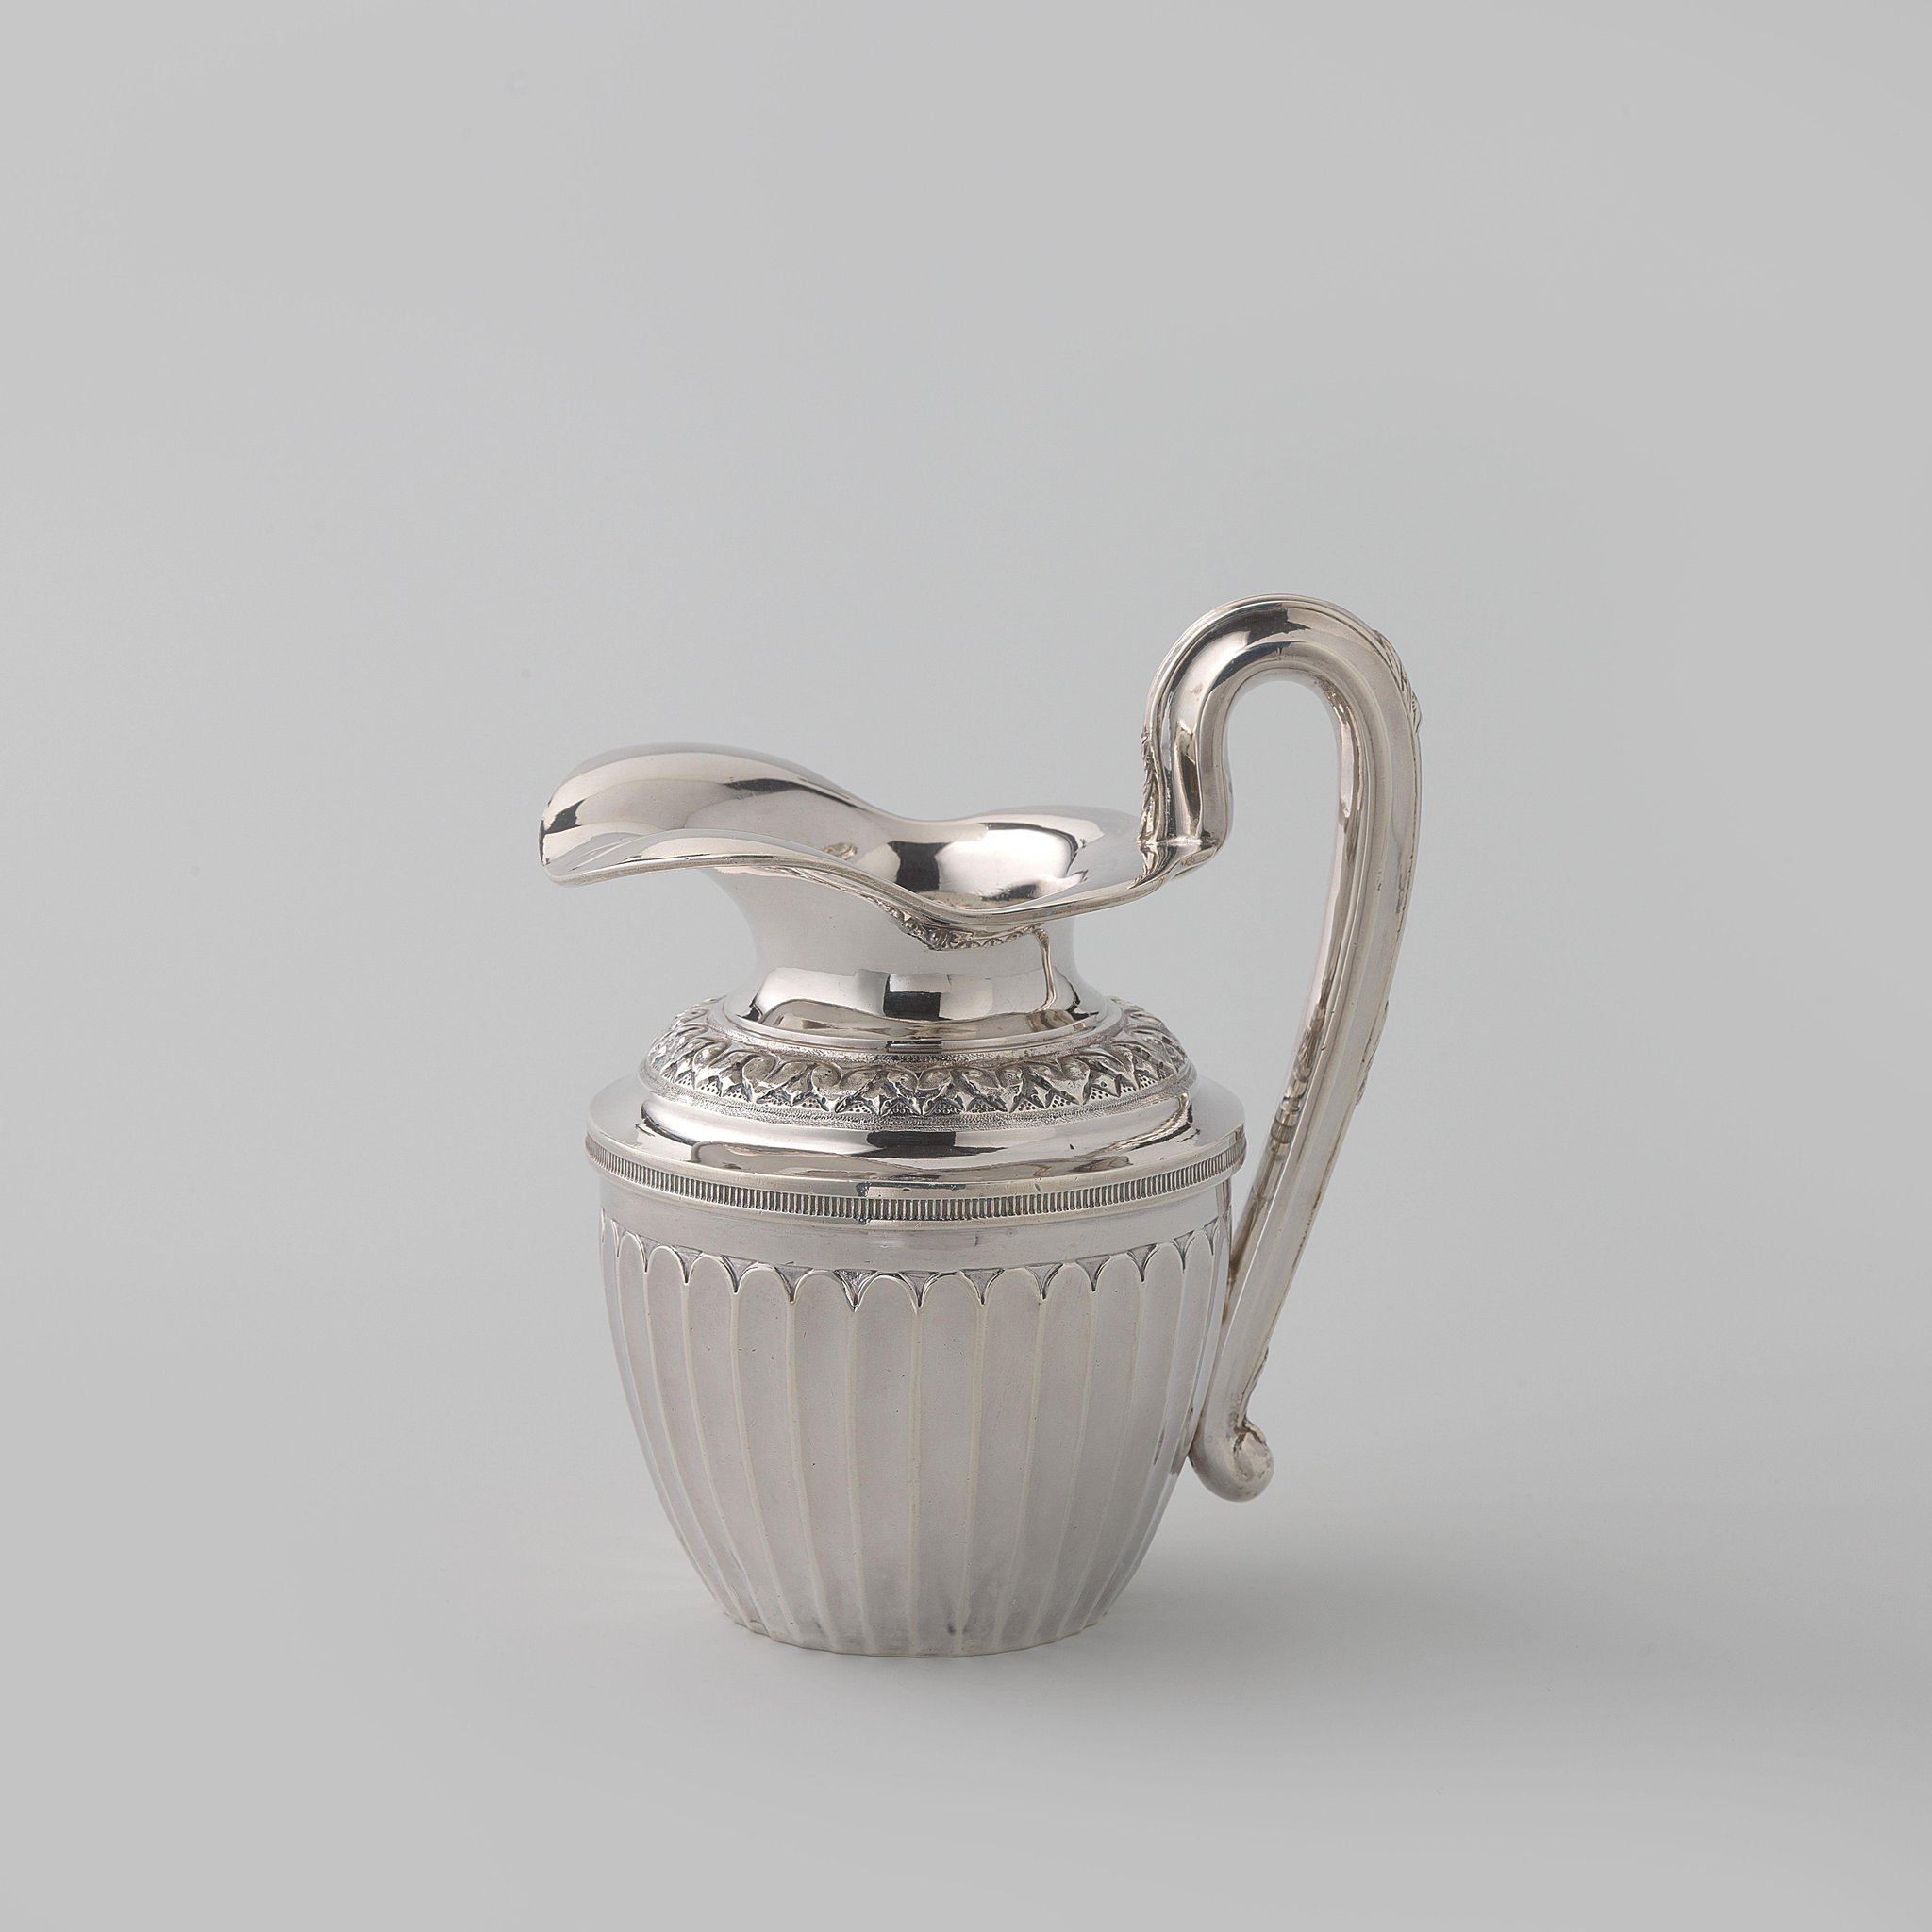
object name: milk jug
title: Melkkan, rond, met cannelures en acanthusblad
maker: lodewijk hendrik held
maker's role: silversmith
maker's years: 1858-1940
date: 1896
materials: silver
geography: amsterdam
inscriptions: alloy mark, assay office mark, maker's mark, date letter: ‘M’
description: Het servies bestaat uit een theepot (BK-15769) met S-vormig gebogen tuit en een vleugelvormig oor, een melkkan (BK-15770) met een soortgelijk kleiner oor en een brede lip, en een suikervaas (BK-15771) op voet met twee soortgelijke, nog kleinere oren. De ronde, zich naar boven verwijdende lichamen van thee- en suikerpot zijn versierd met cannelures, aan de bovenzijde begrensd door een gladde rand, waarboven een iets uitstekende geribde rand. De bovenzijde is opgebouwd uit een brede, iets holle band, een smalle, horizontale, geponste rand, een licht gebold fries van acanthusblad op een gestippeld fond en een smalle geponste rand. Bij de theepot bevindt zich daarboven een opstaande geprofileerde bovenrand, waarin het losse deksel valt. Dit bestaat uit een glad, zich naar boven versmallend ondergedeelte met daarop een klokvormig gedeelte dat aan de bovenzijde gevat is in acanthusblad en aan de onderzijde is begrensd door een parelrand. Hierop rust, verbonden door een diabolovormig tussenstuk, een eikelvormig knopje. De melkkan heeft een diabolovormige hals die overgaat in een brede lip met gelobde rand. De voet van de ronde suikervaas rust op een rechte, geprofileerde basis. Het gedeelte hierboven is zeer verwant aan de bovenzijde van de theepot en de melkkan: een holle band, smalle, horizontale, geponste rand, licht gebolde fries van acanthusblad en smalle geponste rand. Daarboven bevindt zich een glad, naar boven smal toelopend gedeelte waarop de gedrukt bolvormige bak rust, die versierd is zoals de theepot. Boven de acanthusrand bevindt zich een hol uitstaande bovenrand. Alle oren hebben aan de zijkanten holle profielen- en aan de bovenzijde ribbels, op drie plaatsen onderbroken door schuin geplaatste eikenbladen. Het palissanderhouten oor van de theepot heeft voluutvormige zilveren vattingen. De tuit van de theepot is versierd met vier brede groeven.